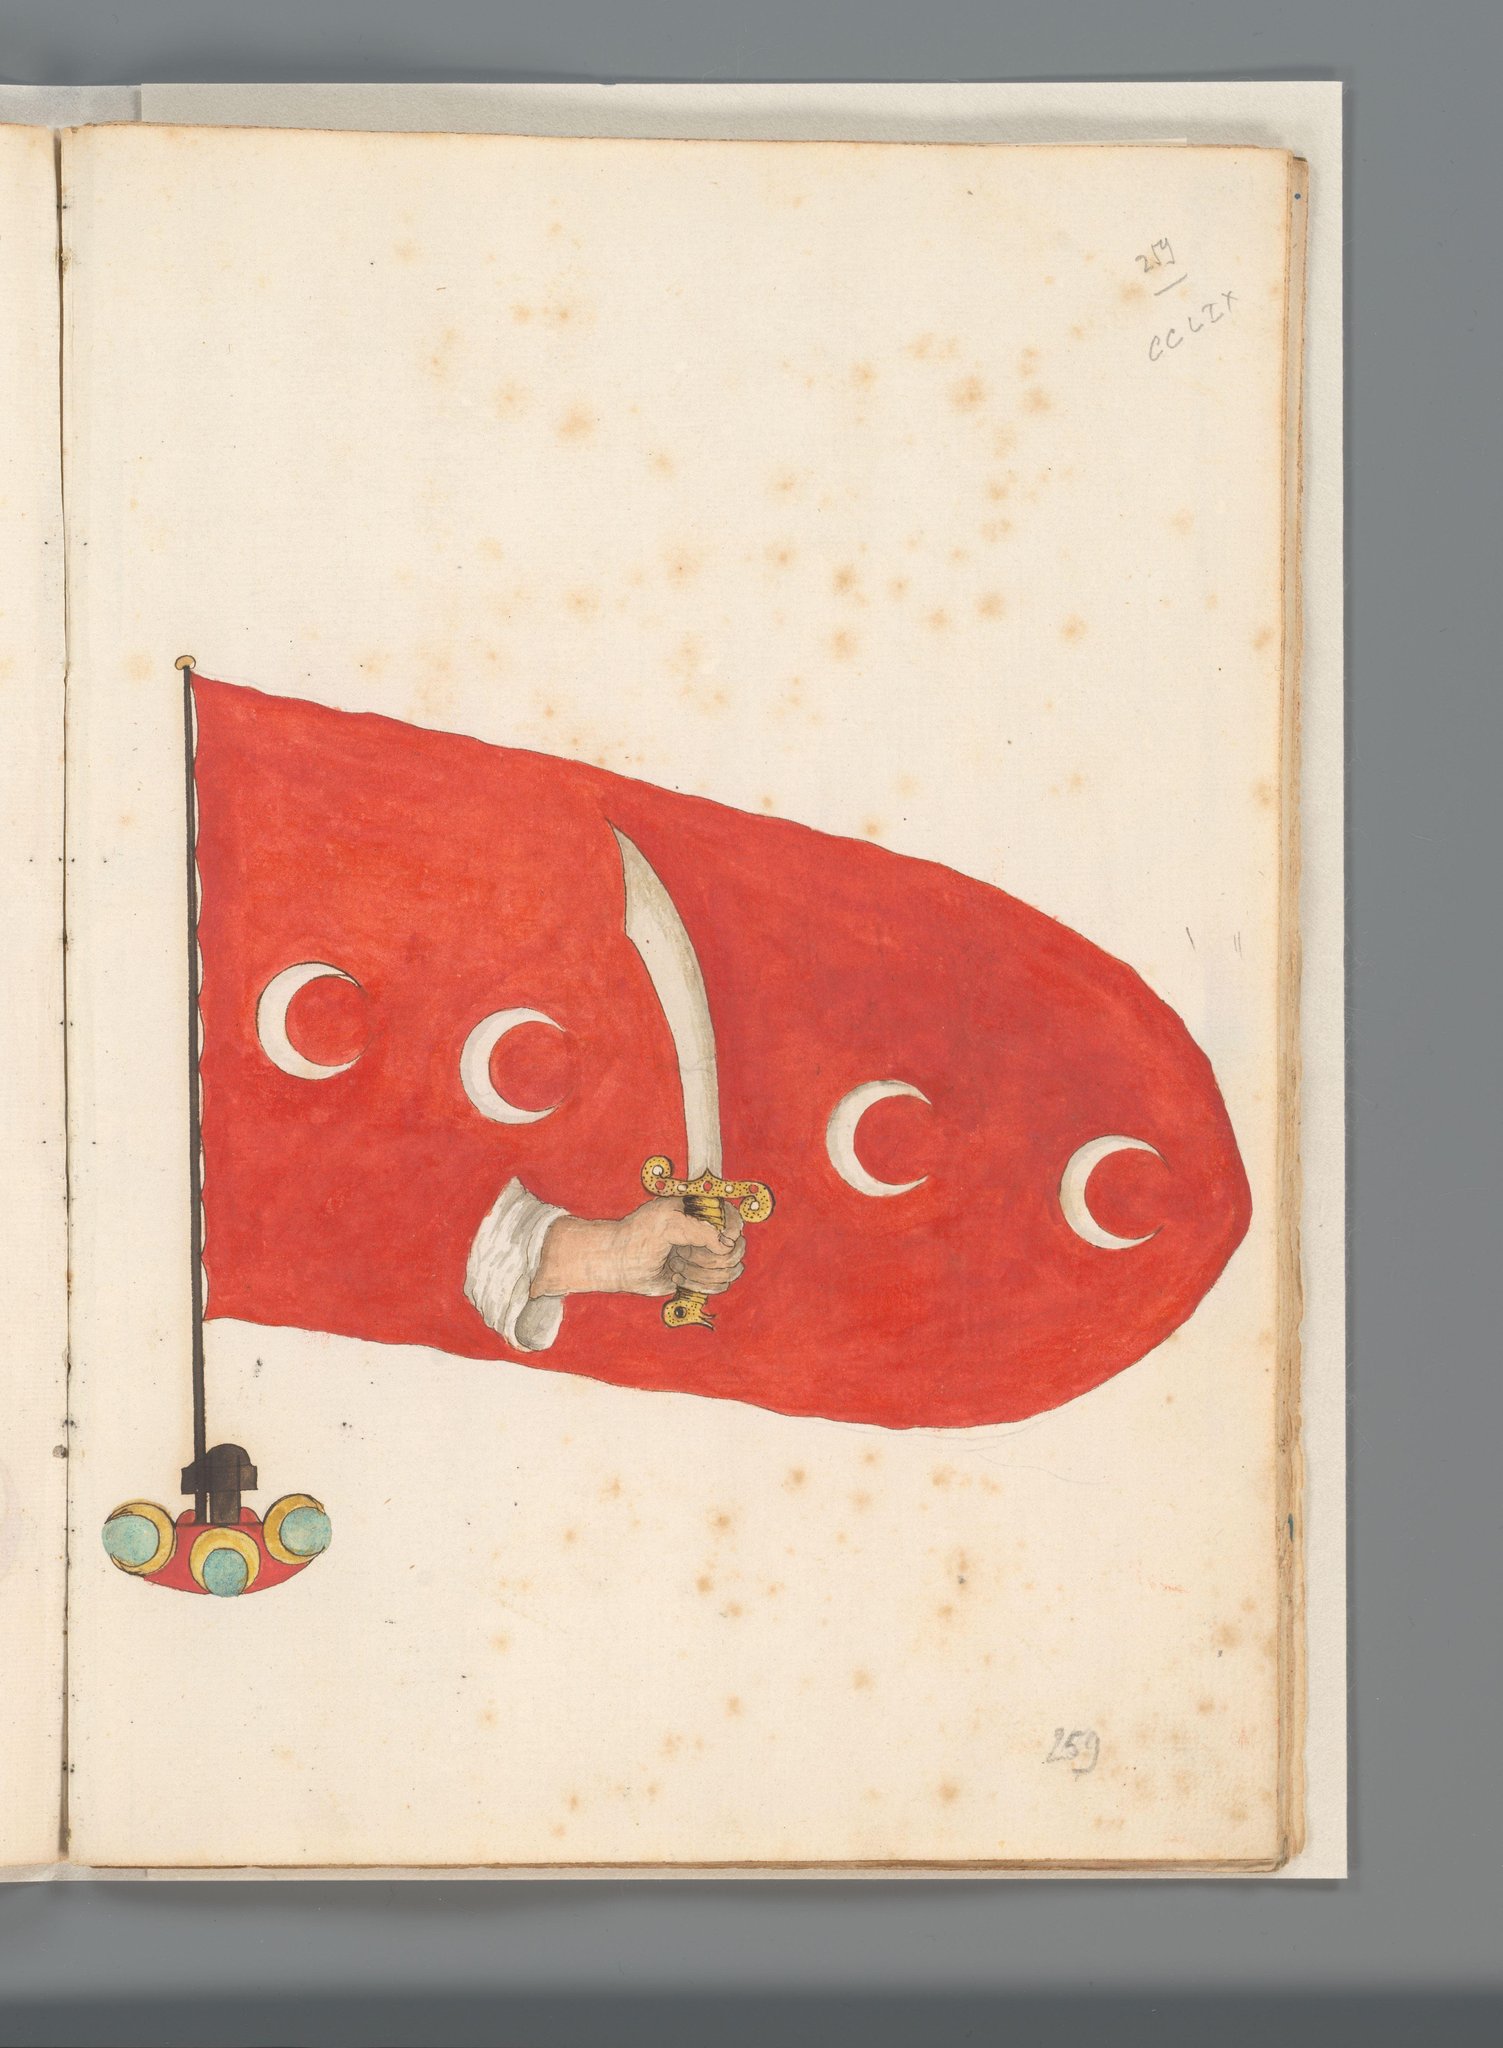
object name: drawing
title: Vlag van een Noord-Afrikaanse staat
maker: Anonymous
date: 1667-1670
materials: ink, paper, watercolor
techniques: brush, pen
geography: france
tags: flag, colours (as symbol of the state, etc.)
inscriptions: number: ‘259 / CCLIX / 259’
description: Vlag van een Noord-Afrikaanse islamitische staat. Rode vlag met een hand met een kromzwaard tussen vier halve manen, met afgeronde vluchtzijde. Vlag op vlaggensteng en mastvoet. Afgebeeld op folio 130r. Onderdeel van een vlaggenboek met vlaggen uit Europa, Noord-Afrika, Nabije en Verre Oosten.